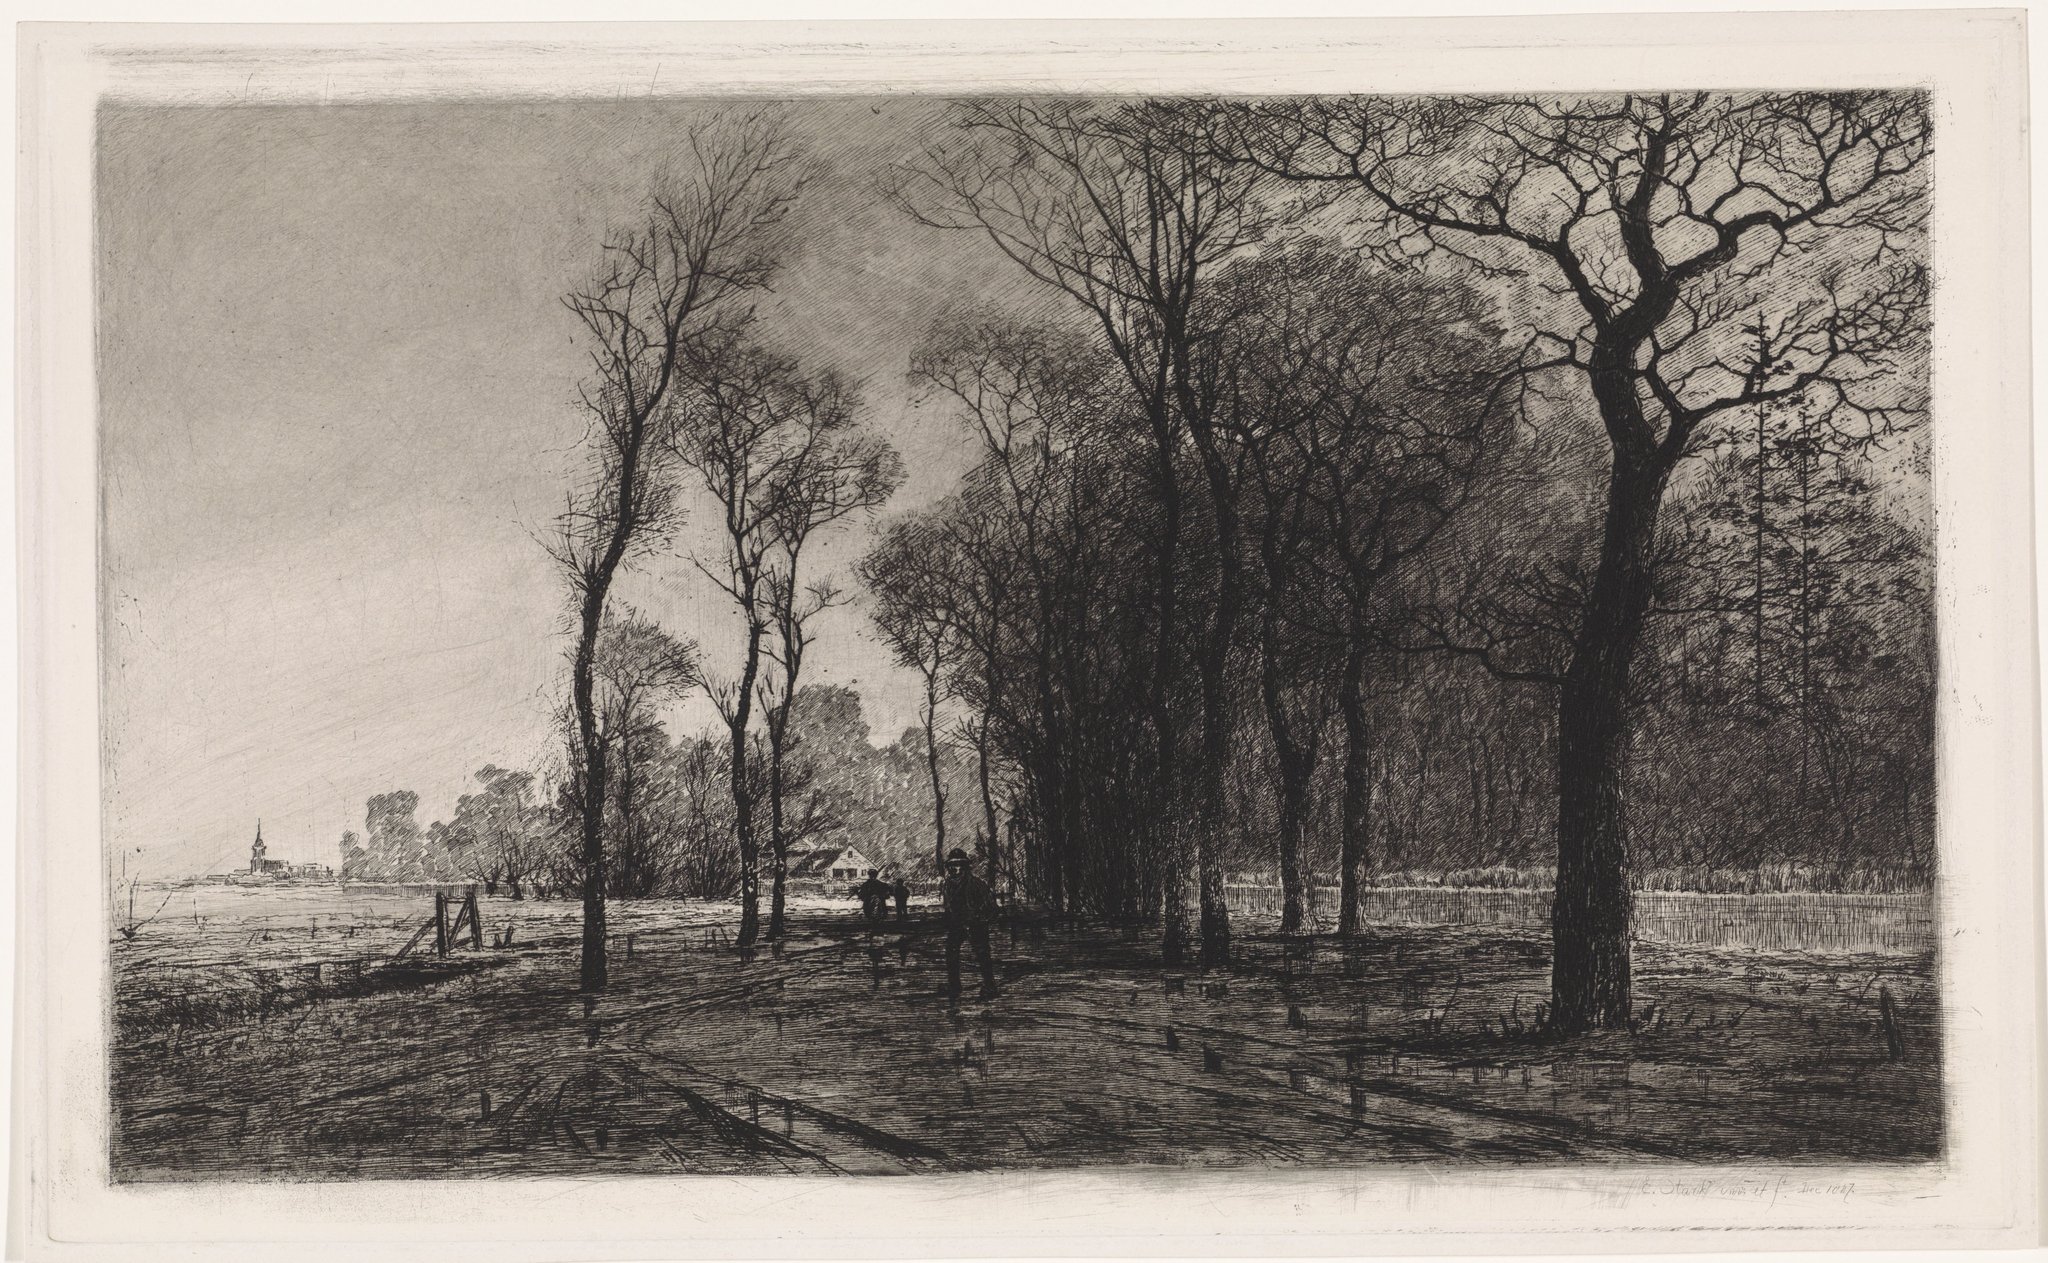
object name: print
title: Drie mensen op een weg met aan weerskanten bomen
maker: elias stark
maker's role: draughtsman, print maker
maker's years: 1849-1933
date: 1812-1887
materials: paper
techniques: aquatint, drypoint, etching, roulette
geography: nieuwer-amstel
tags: trees, river, road, path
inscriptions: collector's mark: Lugt 2228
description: Tussen de bomen loopt een man op klompen. Op de achtergrond lopen een vrouw en een man. Links de rivier de Amstel.